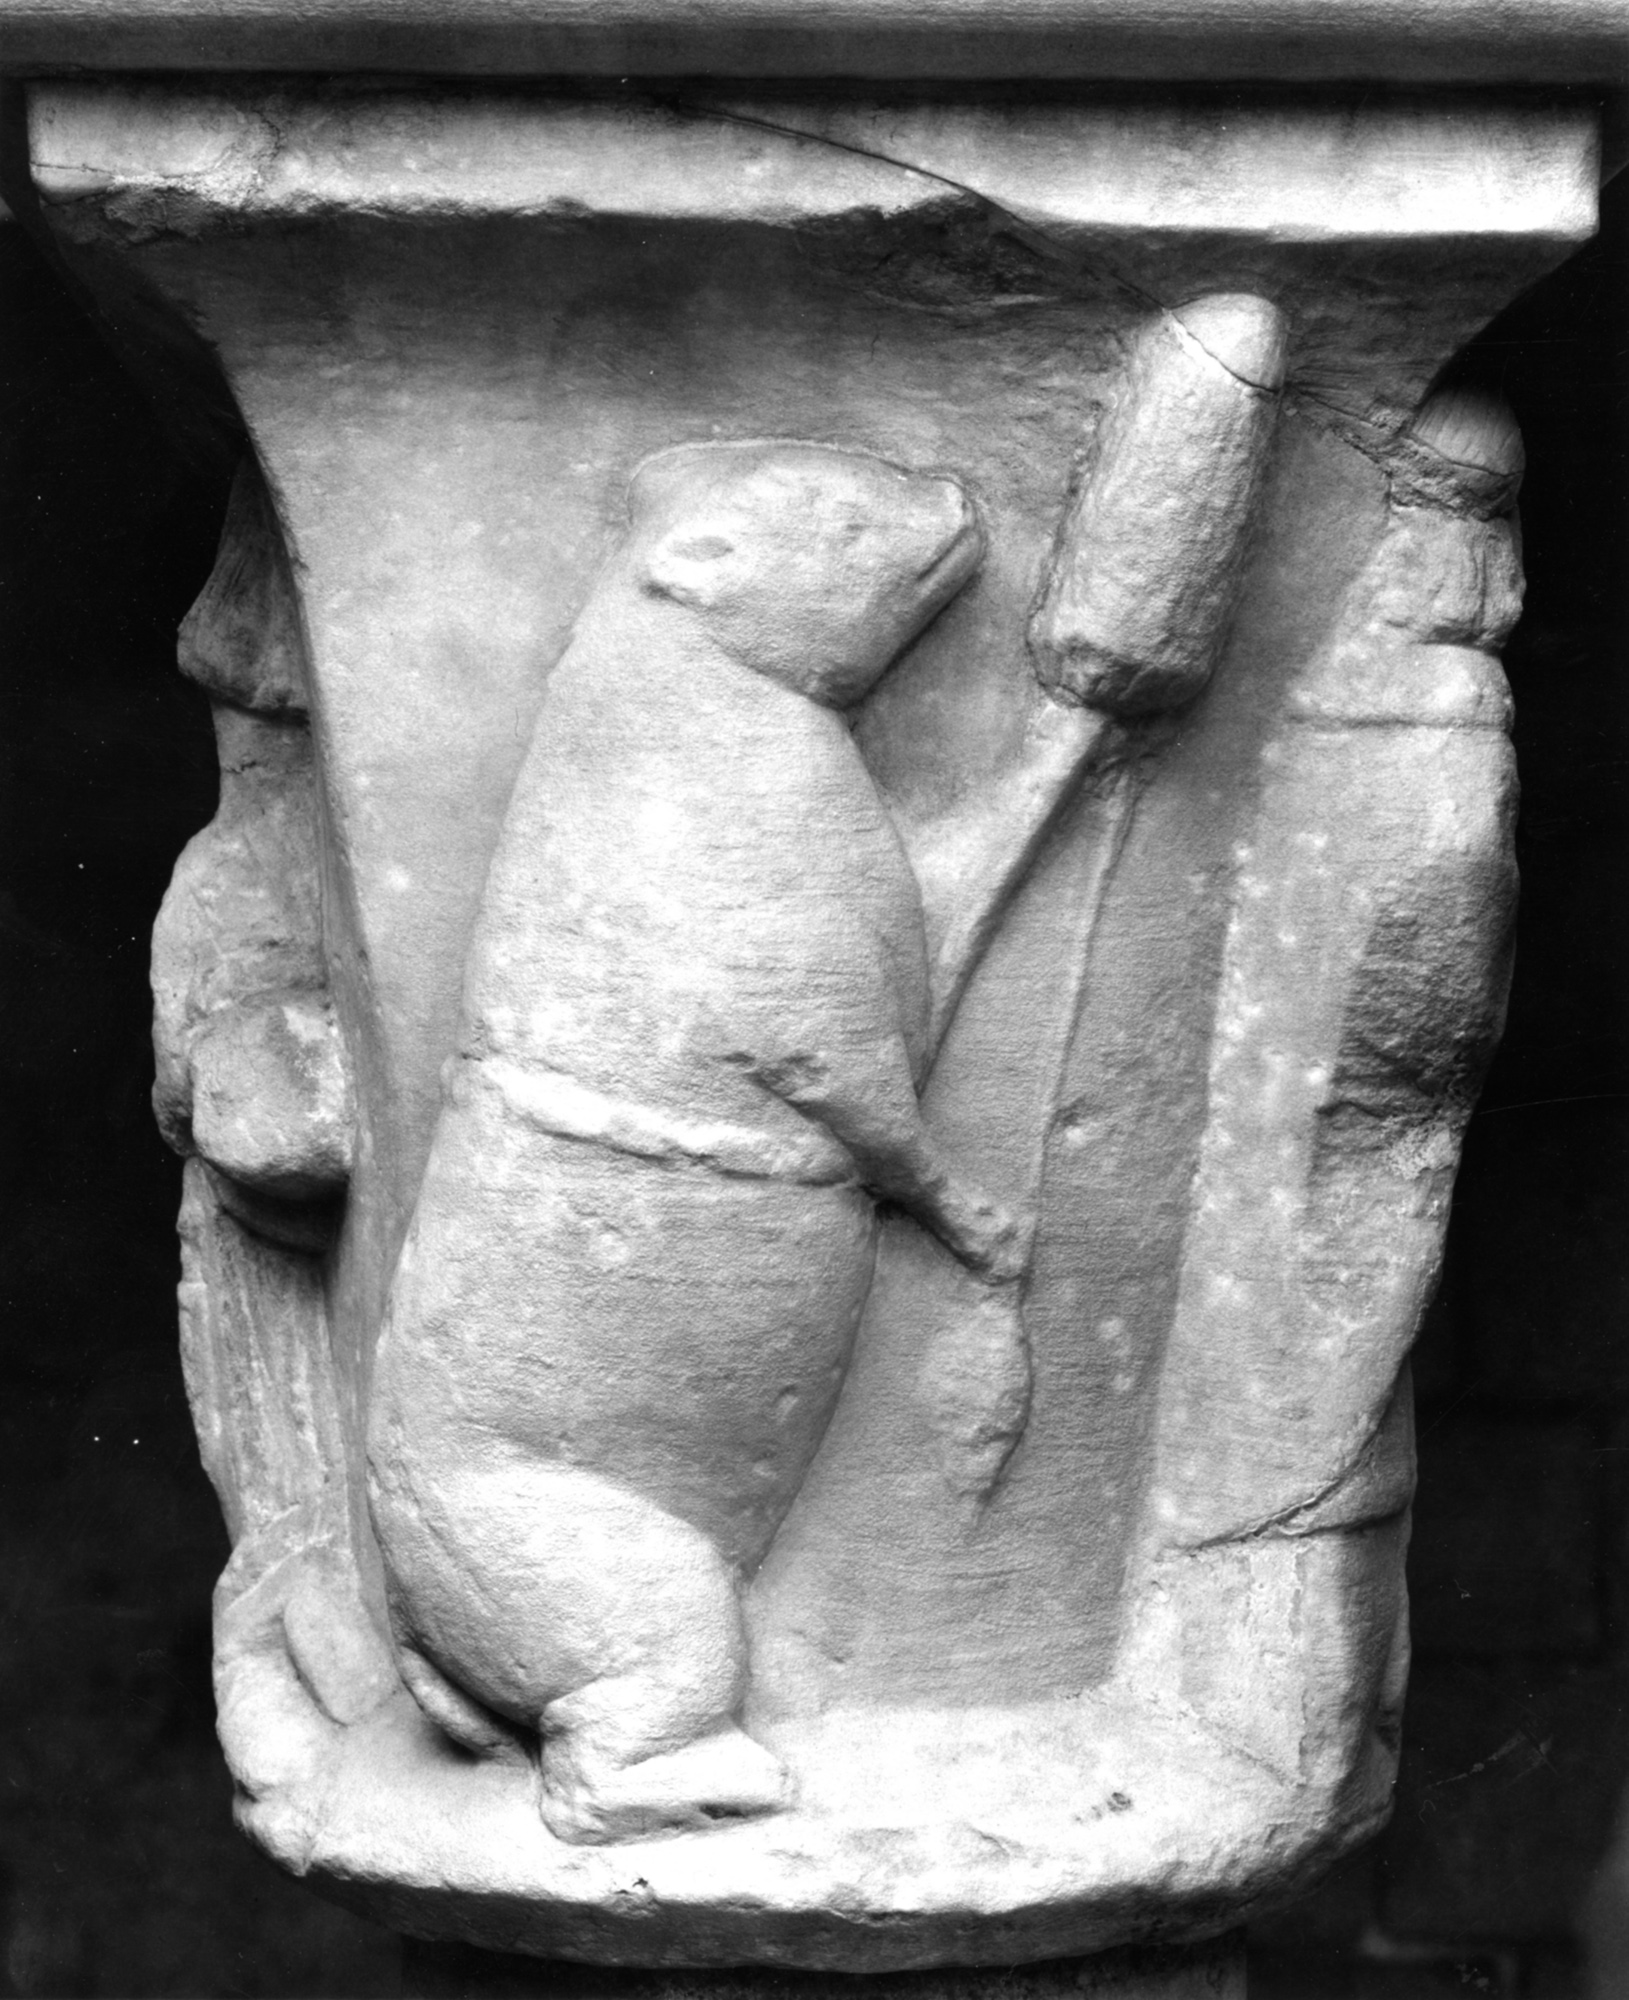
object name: capital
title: Double Capital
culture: french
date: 1467-1500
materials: marble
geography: france